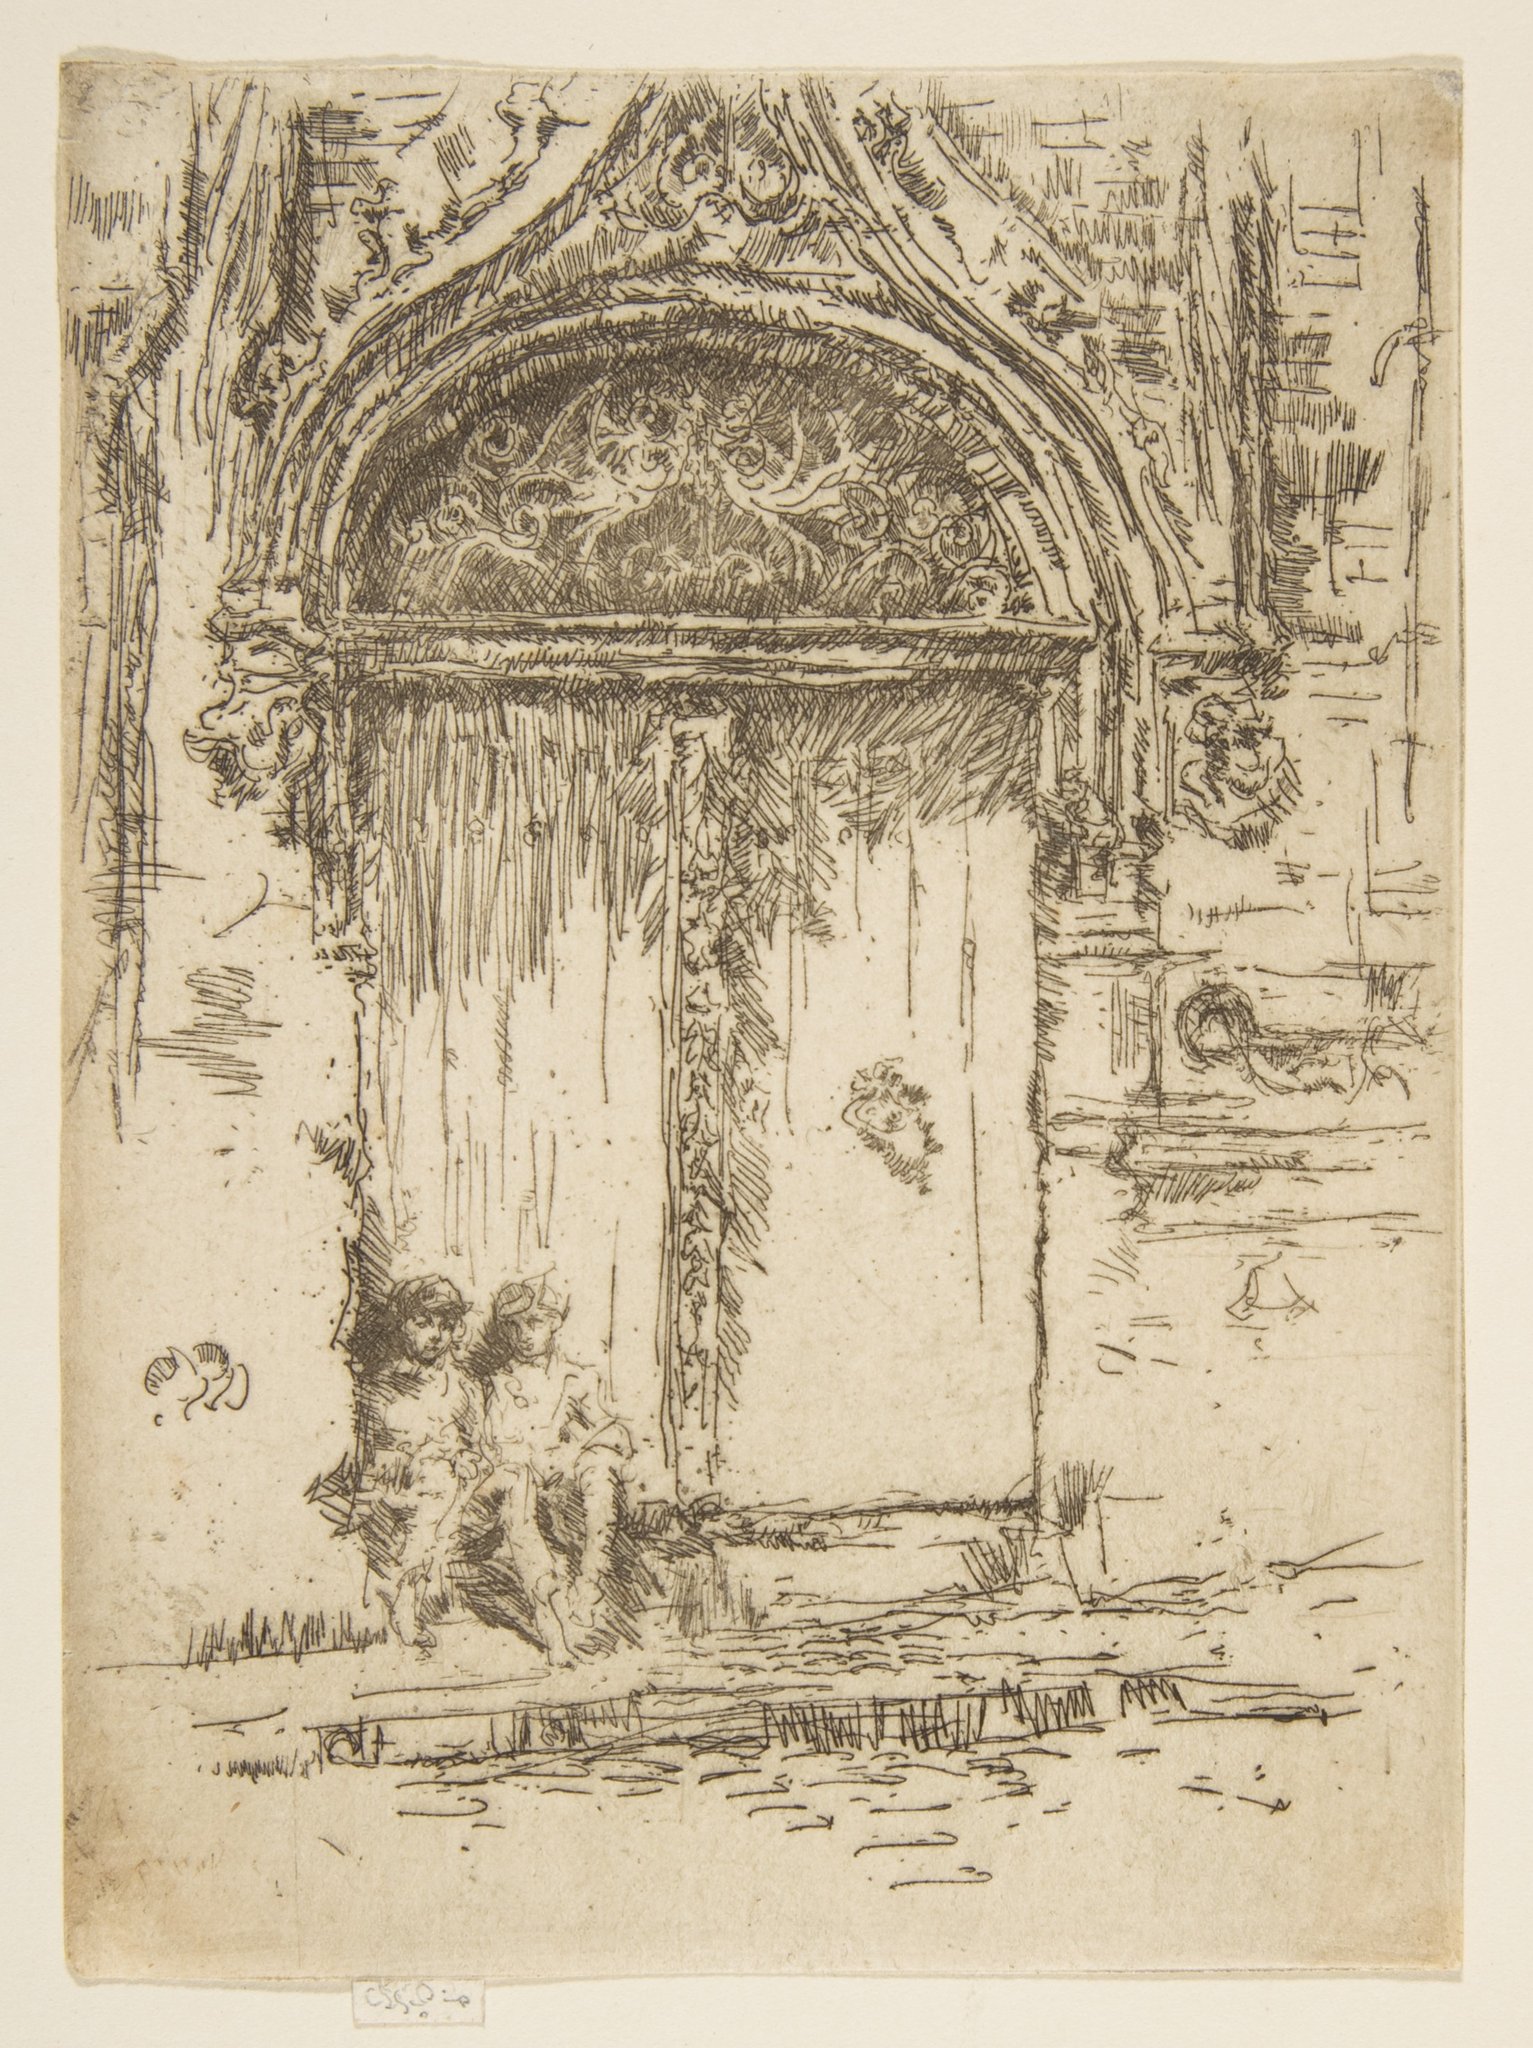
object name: print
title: Hangman's House, Tours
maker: james mcneill whistler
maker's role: artist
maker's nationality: american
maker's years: 1834-1903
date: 1888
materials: ink, paper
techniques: drypoint, etching, printing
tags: human figures,houses